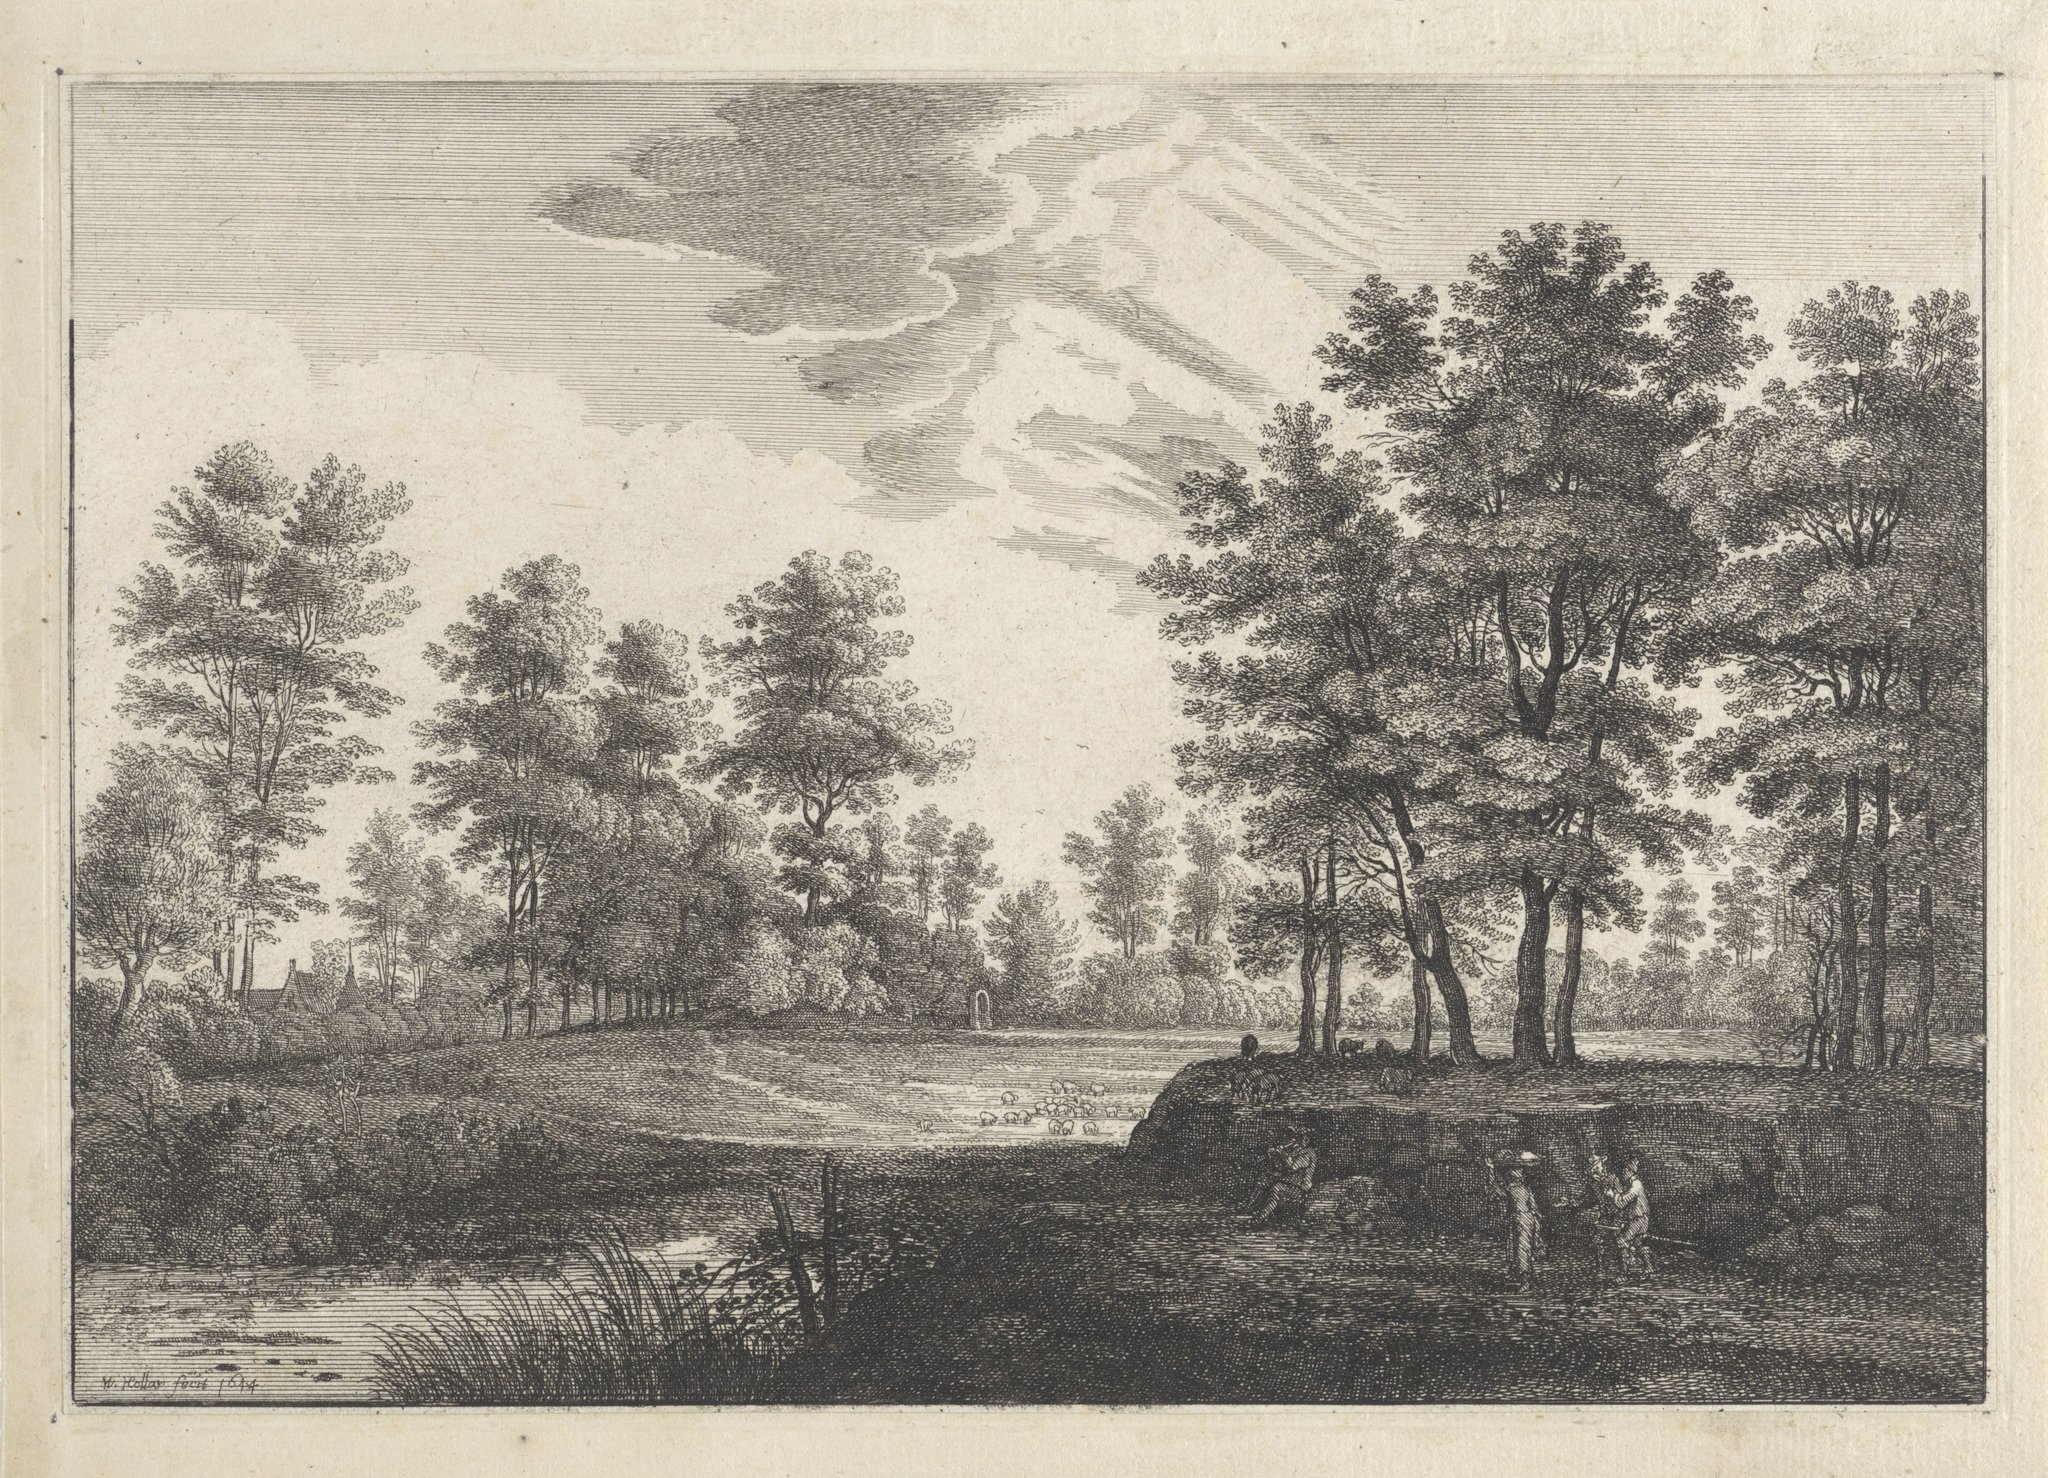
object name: print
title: Landschap met figuren en een kudde schapen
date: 1644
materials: paper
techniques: etching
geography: antwerp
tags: herding, herdsman, herdswoman, shepherd, shepherdess, cowherd, etc., landscapes with waters, waterscapes, seascapes (in the temperate zone), sheep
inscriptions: collector's mark: Lugt 240